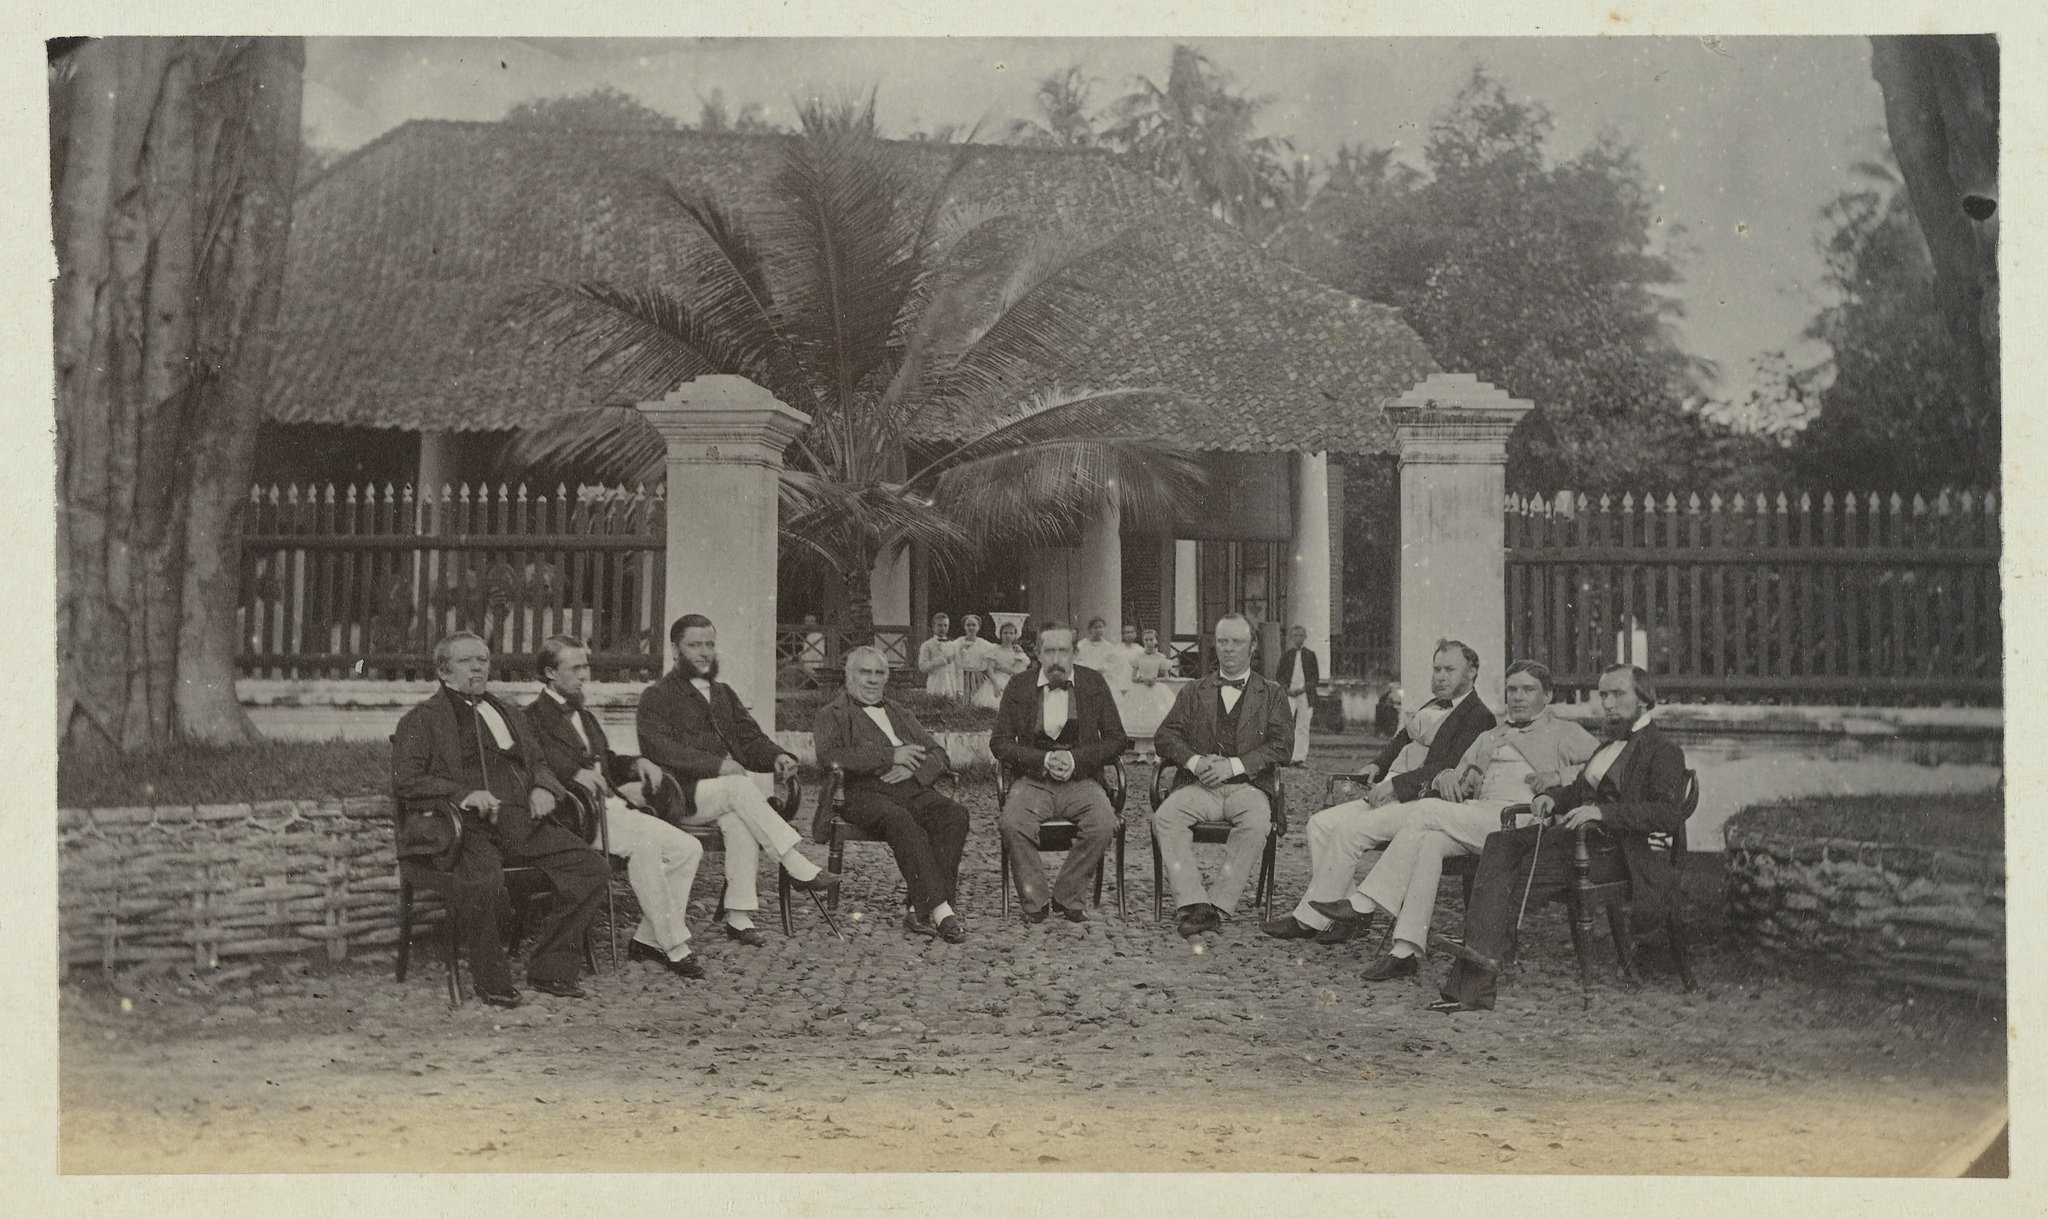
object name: photograph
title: Groepsportret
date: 1863-1869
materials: photographic support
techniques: albumen print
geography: java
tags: club, meeting place, java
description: Portret van een groep mannen, zittend op stoelen bij de ingang naar een gebouw. Mogelijk bestuursleden van een school of instelling. Onderdeel van het groene fotoalbum met foto's van Java, uit het bezit van apotheker Specht-Grijp, die in 1865 vanuit Batavia naar Nederland terugkeerde.